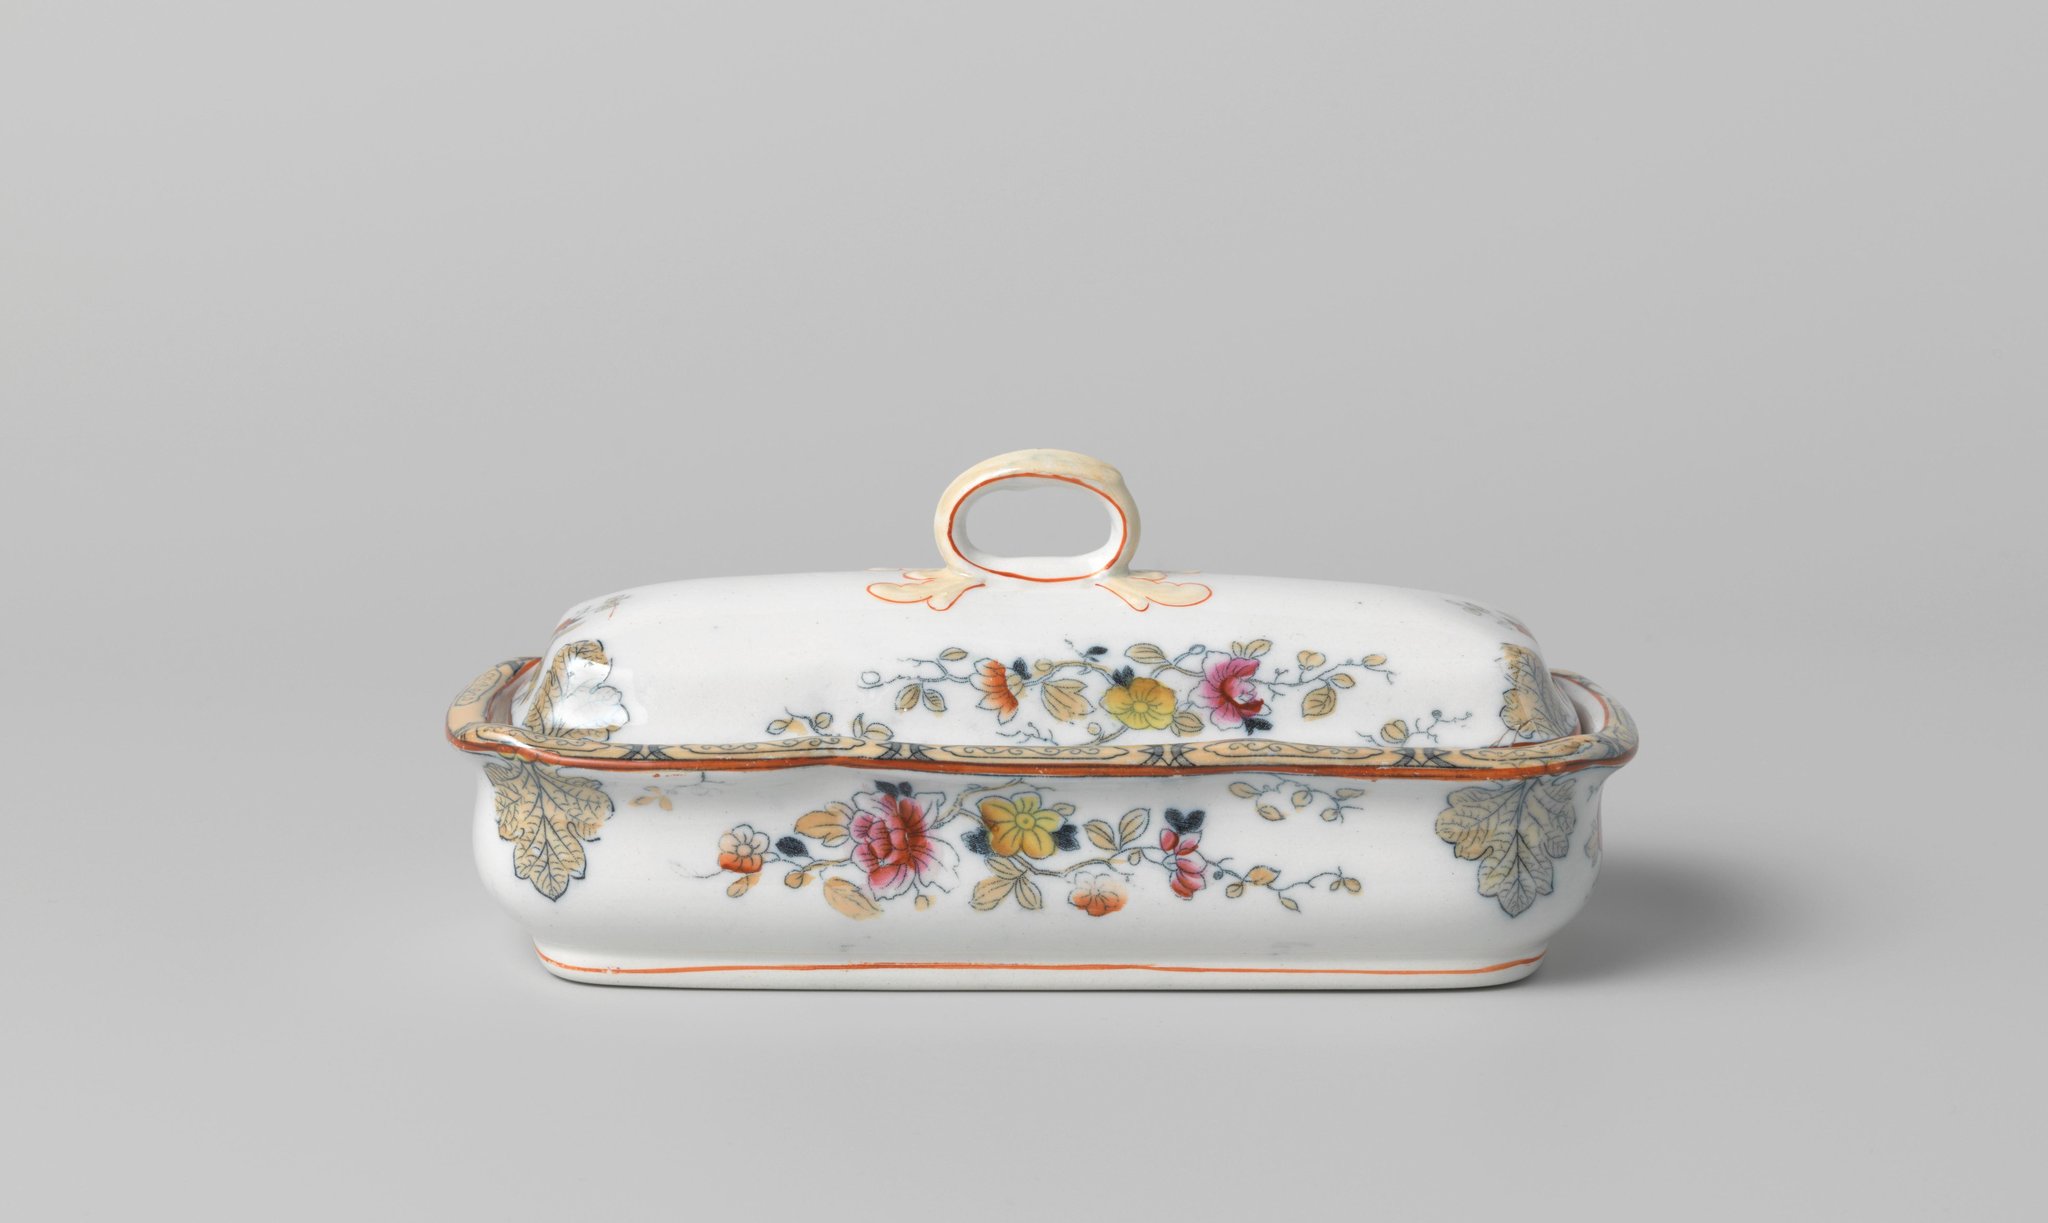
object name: container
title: Kammenbak met deksel met veelkleurige bloemen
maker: petrus regout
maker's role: plateelbakker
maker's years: 1801-1879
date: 1882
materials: earthenware, glaze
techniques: vitrification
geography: maastricht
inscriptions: check stamp: ‘F BM’, mark: ‘sfinx // P. REGOUT & Co // MAASTRICHT // VESTA’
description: Bak met deksel van aardewerk met blauwzwart transferdecor, beschilderd met moffelkleuren en okerluster. De rechthoekige bak heeft afgeronde hoeken en een gewelfde wand. De bodem wordt door twee opstaande randen in drie vakken verdeeld. De wand met veelkleurige bloemen en bladeren. De uitstekende bovenrand van de wand is gedecoreerd met een abstract motief onder okerluster. Het rechthoekige, gewelfde deksel heeft langs de rand een band van veelkleurige bloemen en bladeren. Het deksel wordt bekroond door een knop in de vorm van omgekruld bladwerk.